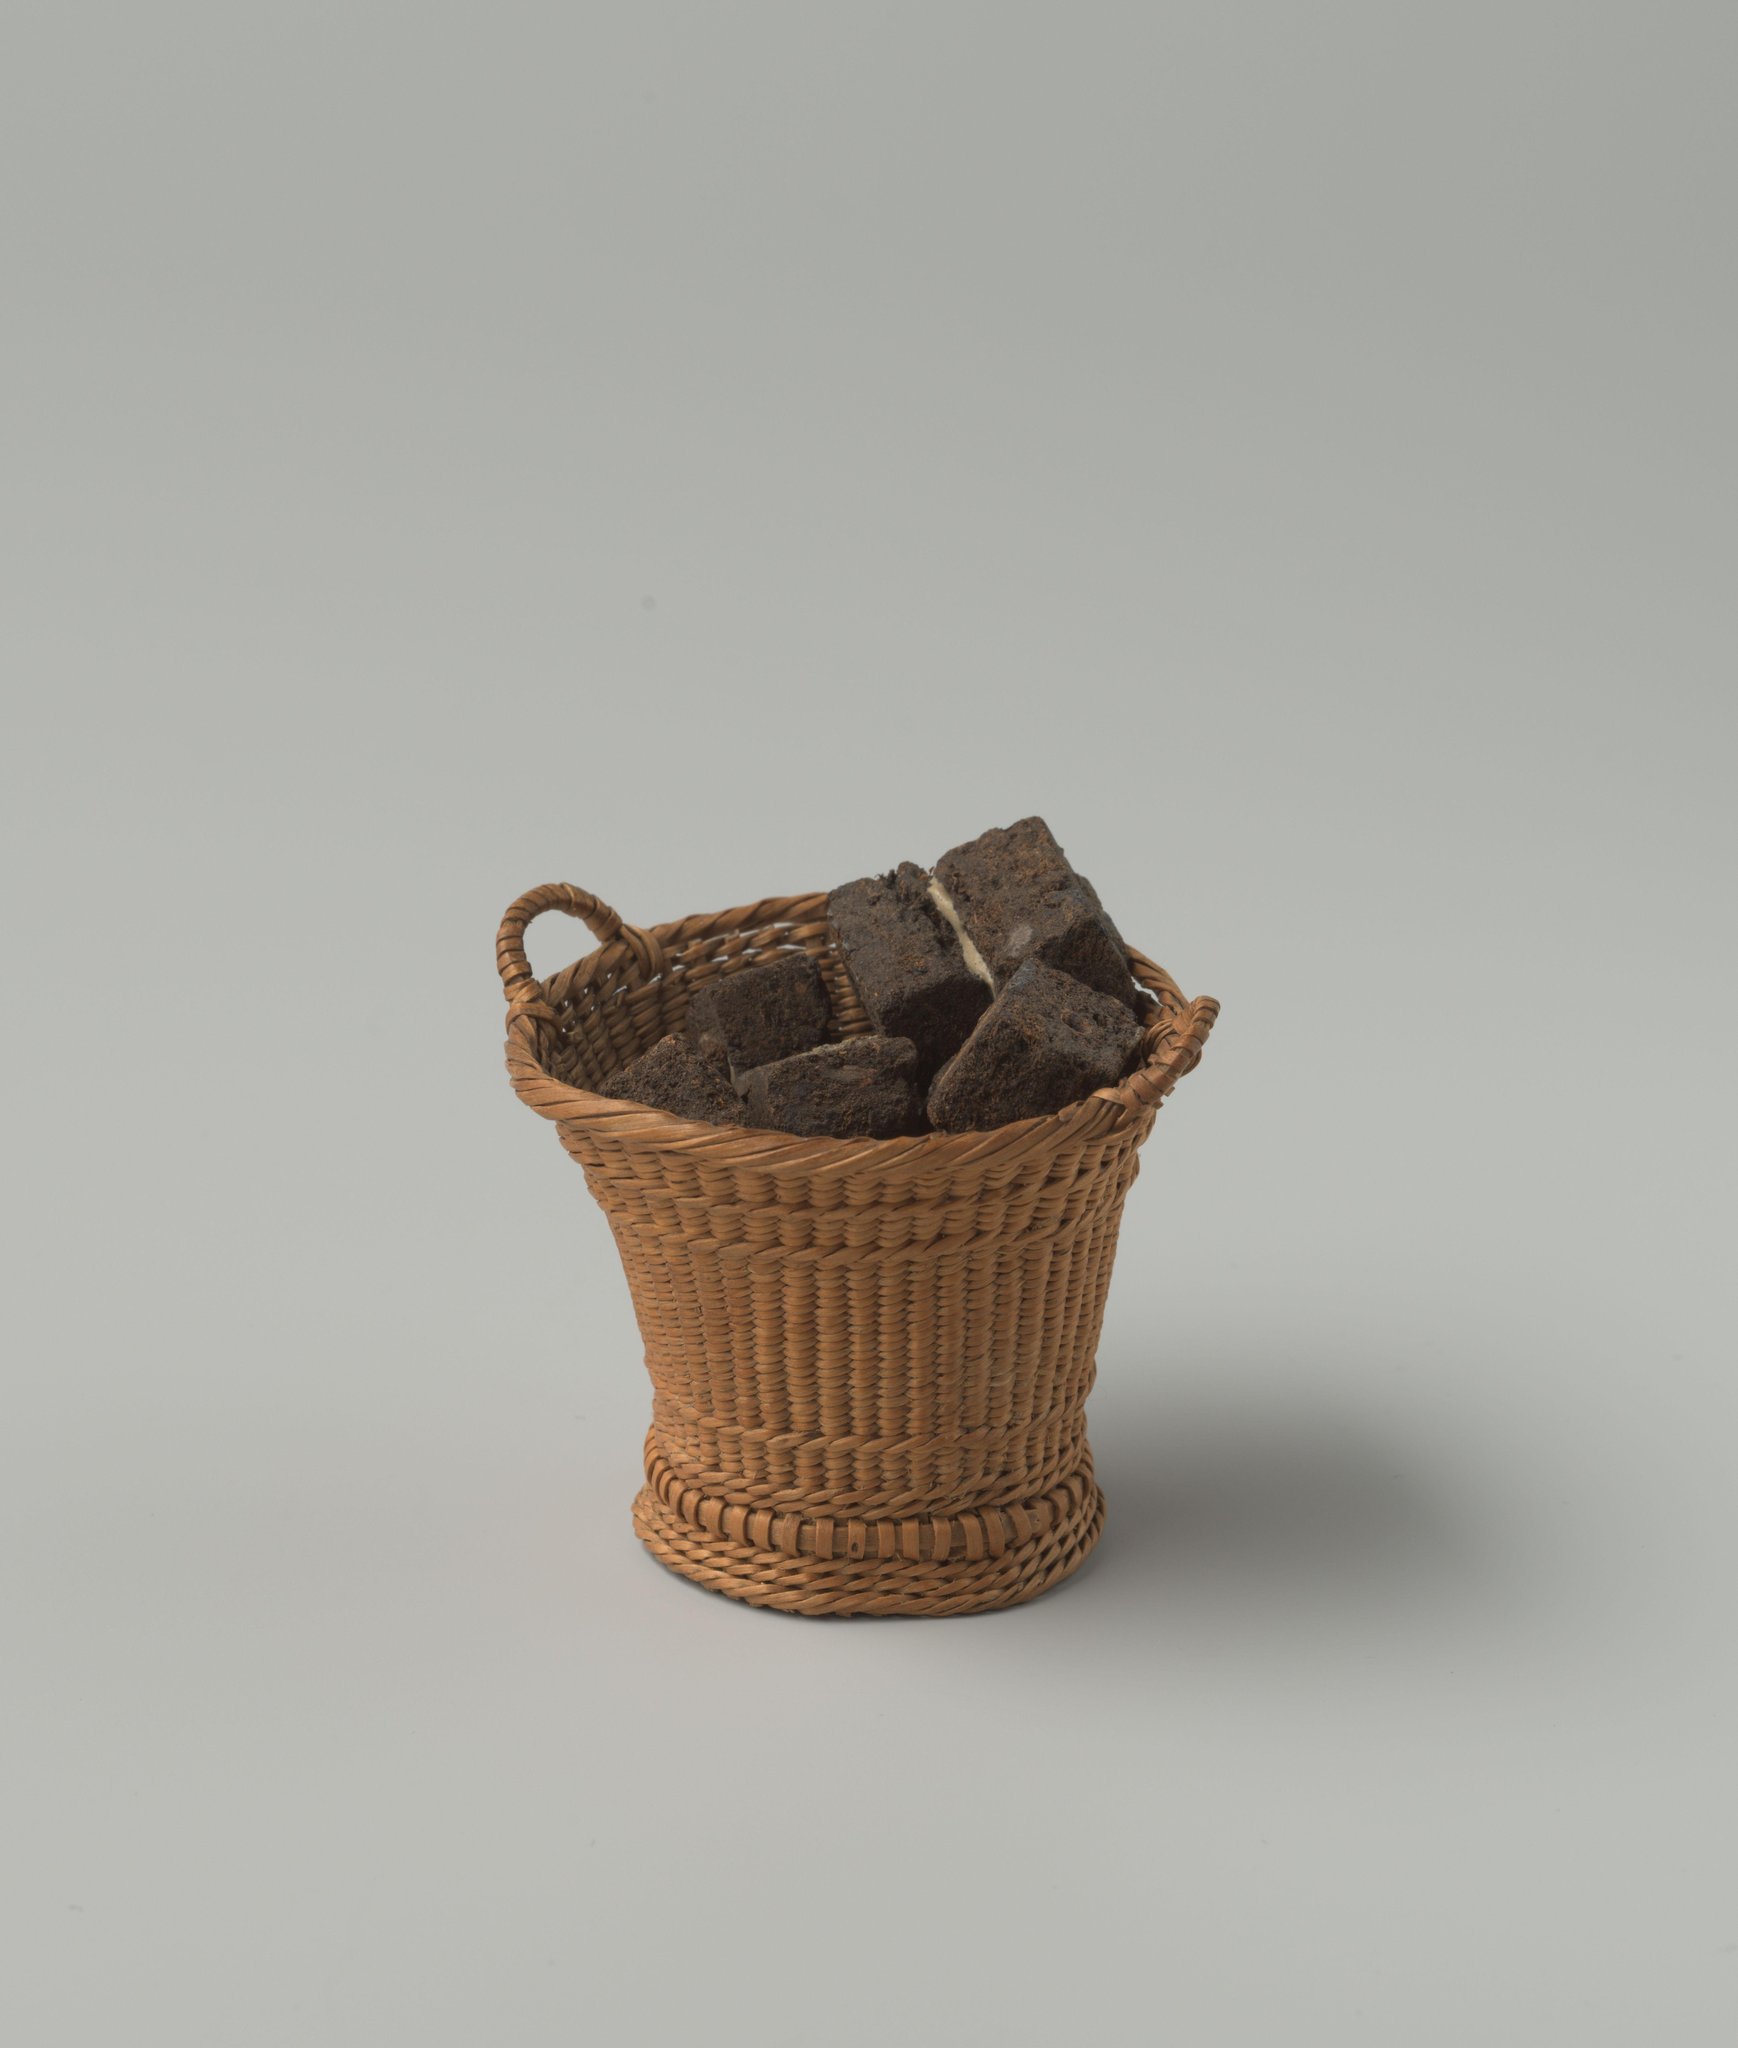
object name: miniature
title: Ronde hoge turfmand van gespleten wilgenteen, fijnscheenwerk, met twee handvatten; gevuld met blokjes turf.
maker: Anonymous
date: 1675-1710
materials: plant material, peat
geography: halle